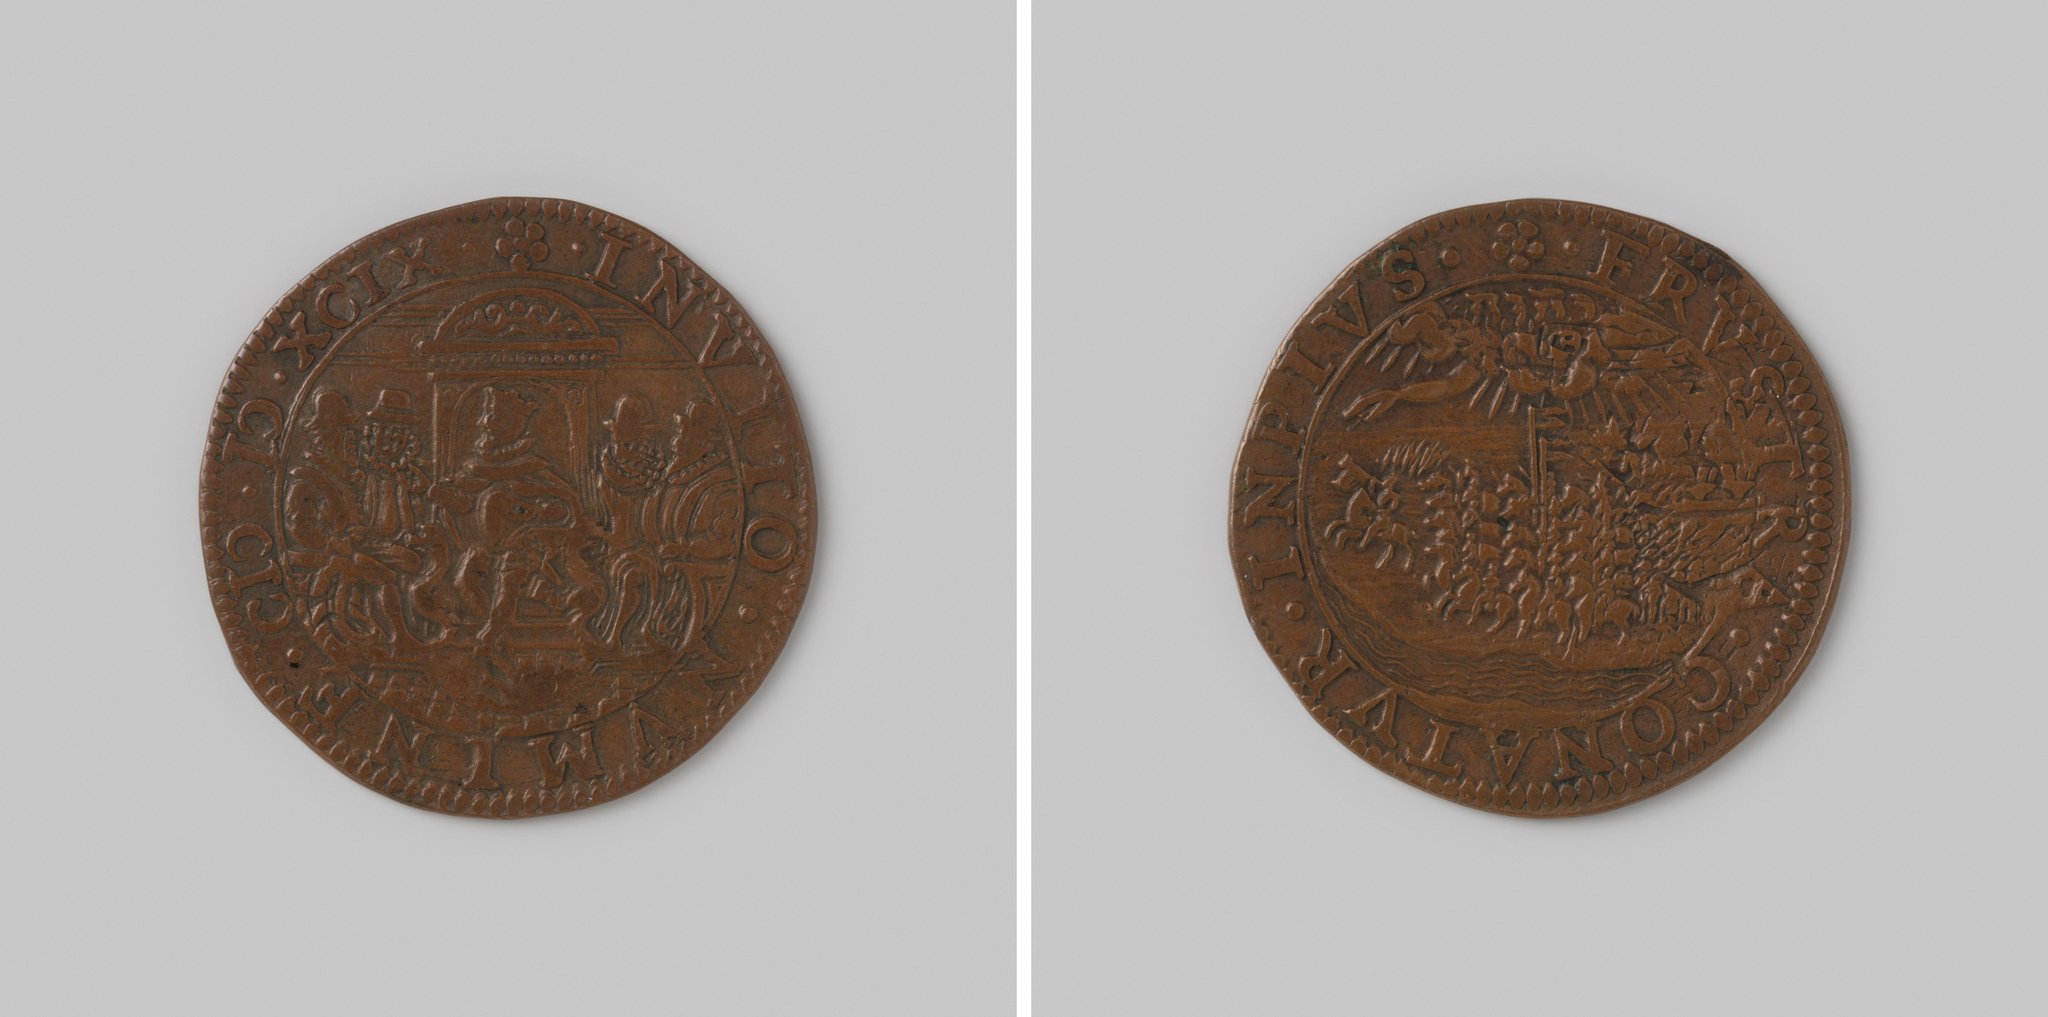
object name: history medal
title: Rekenpenning uit Dordrecht op de veldtocht langs de Rijn door Kardinaal Andreas van Oostenrijk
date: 1599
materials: copper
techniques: striking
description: Koperen penning, op de voorzijde Mendoza op een troon overleggend met vier heren, met omschrift, op de keerzijde een hand uit de hemel die een leger langs een rivier tracht te stoppen, met omschrift.